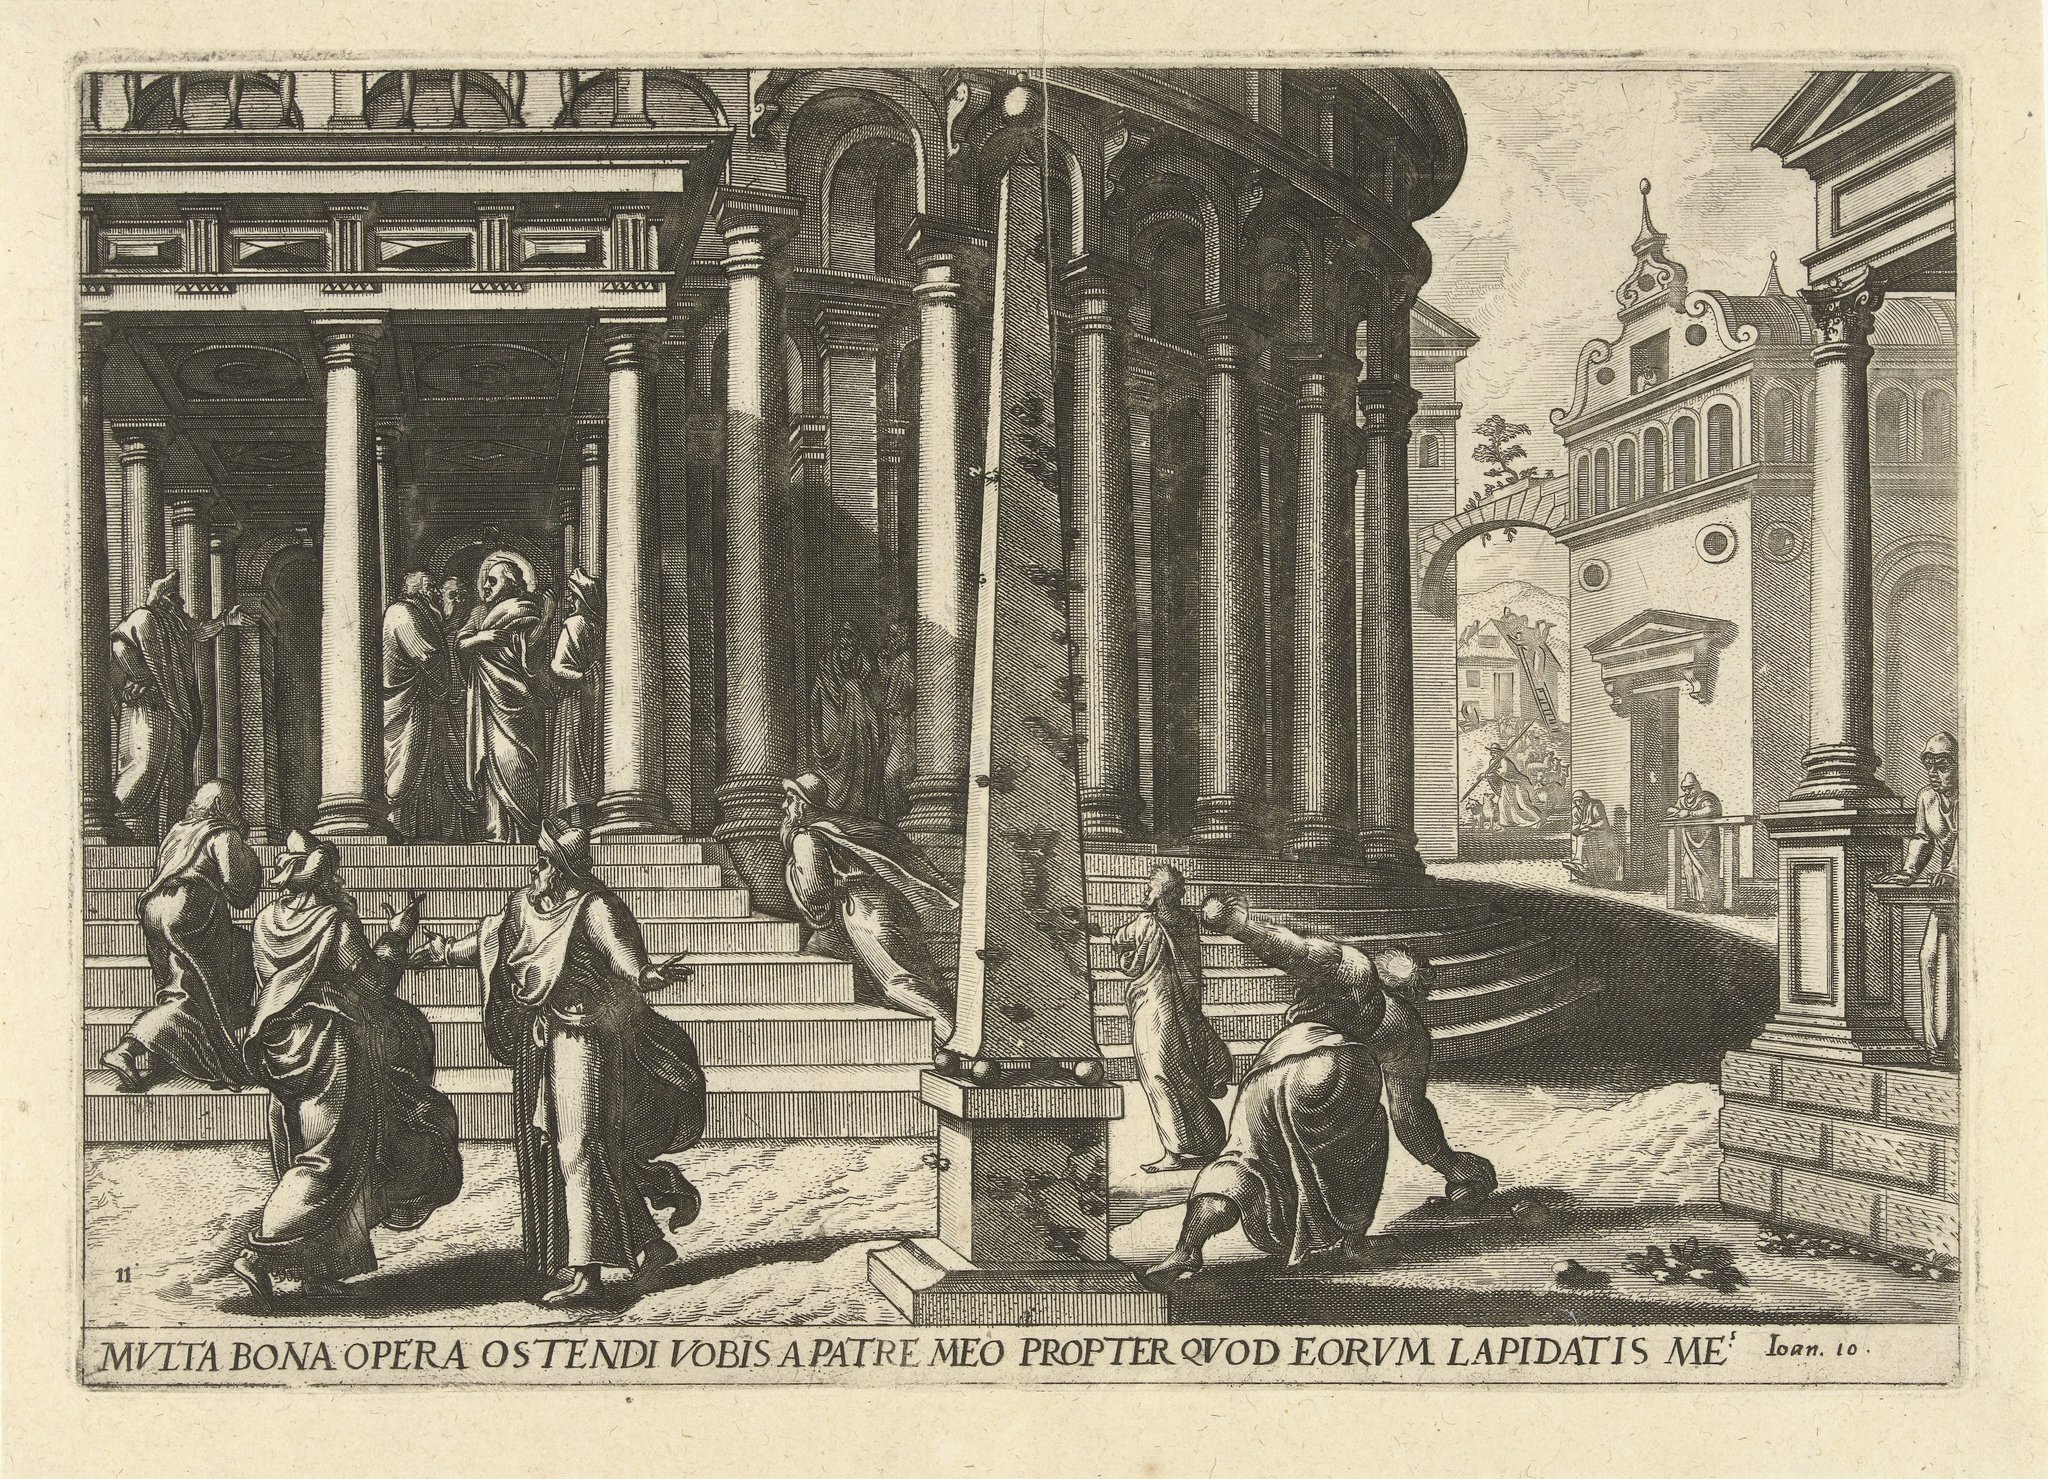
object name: print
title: Christus in de zuilengang van Salomo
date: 1572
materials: paper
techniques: engraving, etching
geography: antwerp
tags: attempts to stone christ (john 8:59, 10:31-33)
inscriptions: collector's mark: Lugt 2760, collector's mark: Lugt 2228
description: Christus loopt door de zuilengang van Salomo in de tempel. Een groep joden ondervraagt hem. Ze willen weten of hij de Messias is of niet. Sommigen worden boos over Christus' antwoorden en grijpen naar stenen.